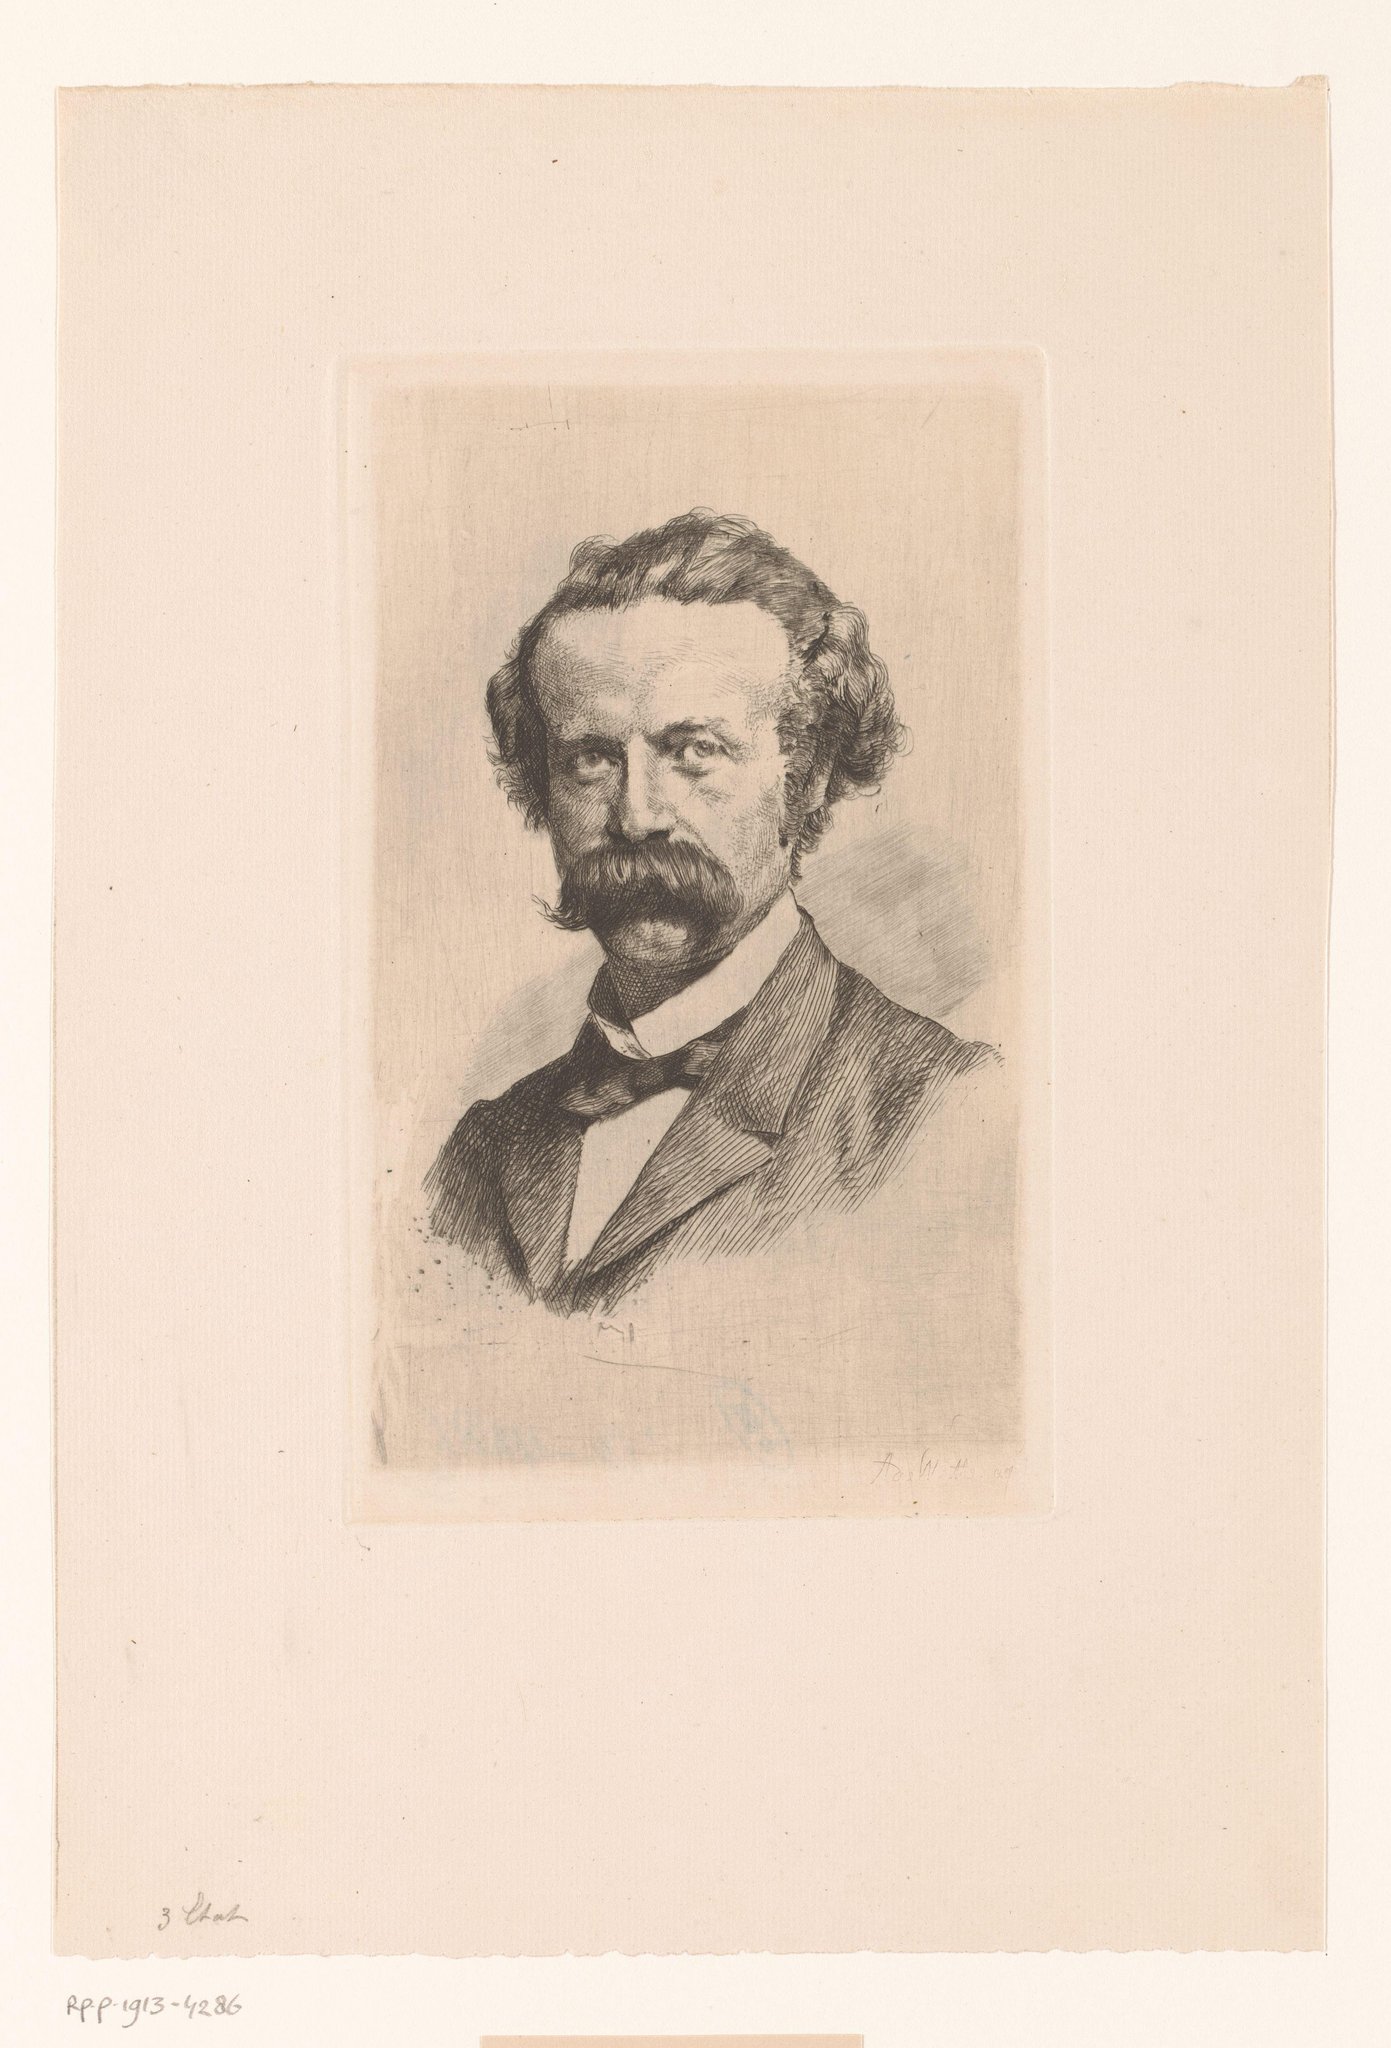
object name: print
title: Portret van een onbekende man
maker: adrien de witte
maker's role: print maker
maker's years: 1850-1935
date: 1860-1913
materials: paper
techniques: drypoint, etching, intaglio, retroussage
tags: moustache, adult man, historical persons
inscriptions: collector's mark: Lugt 2228